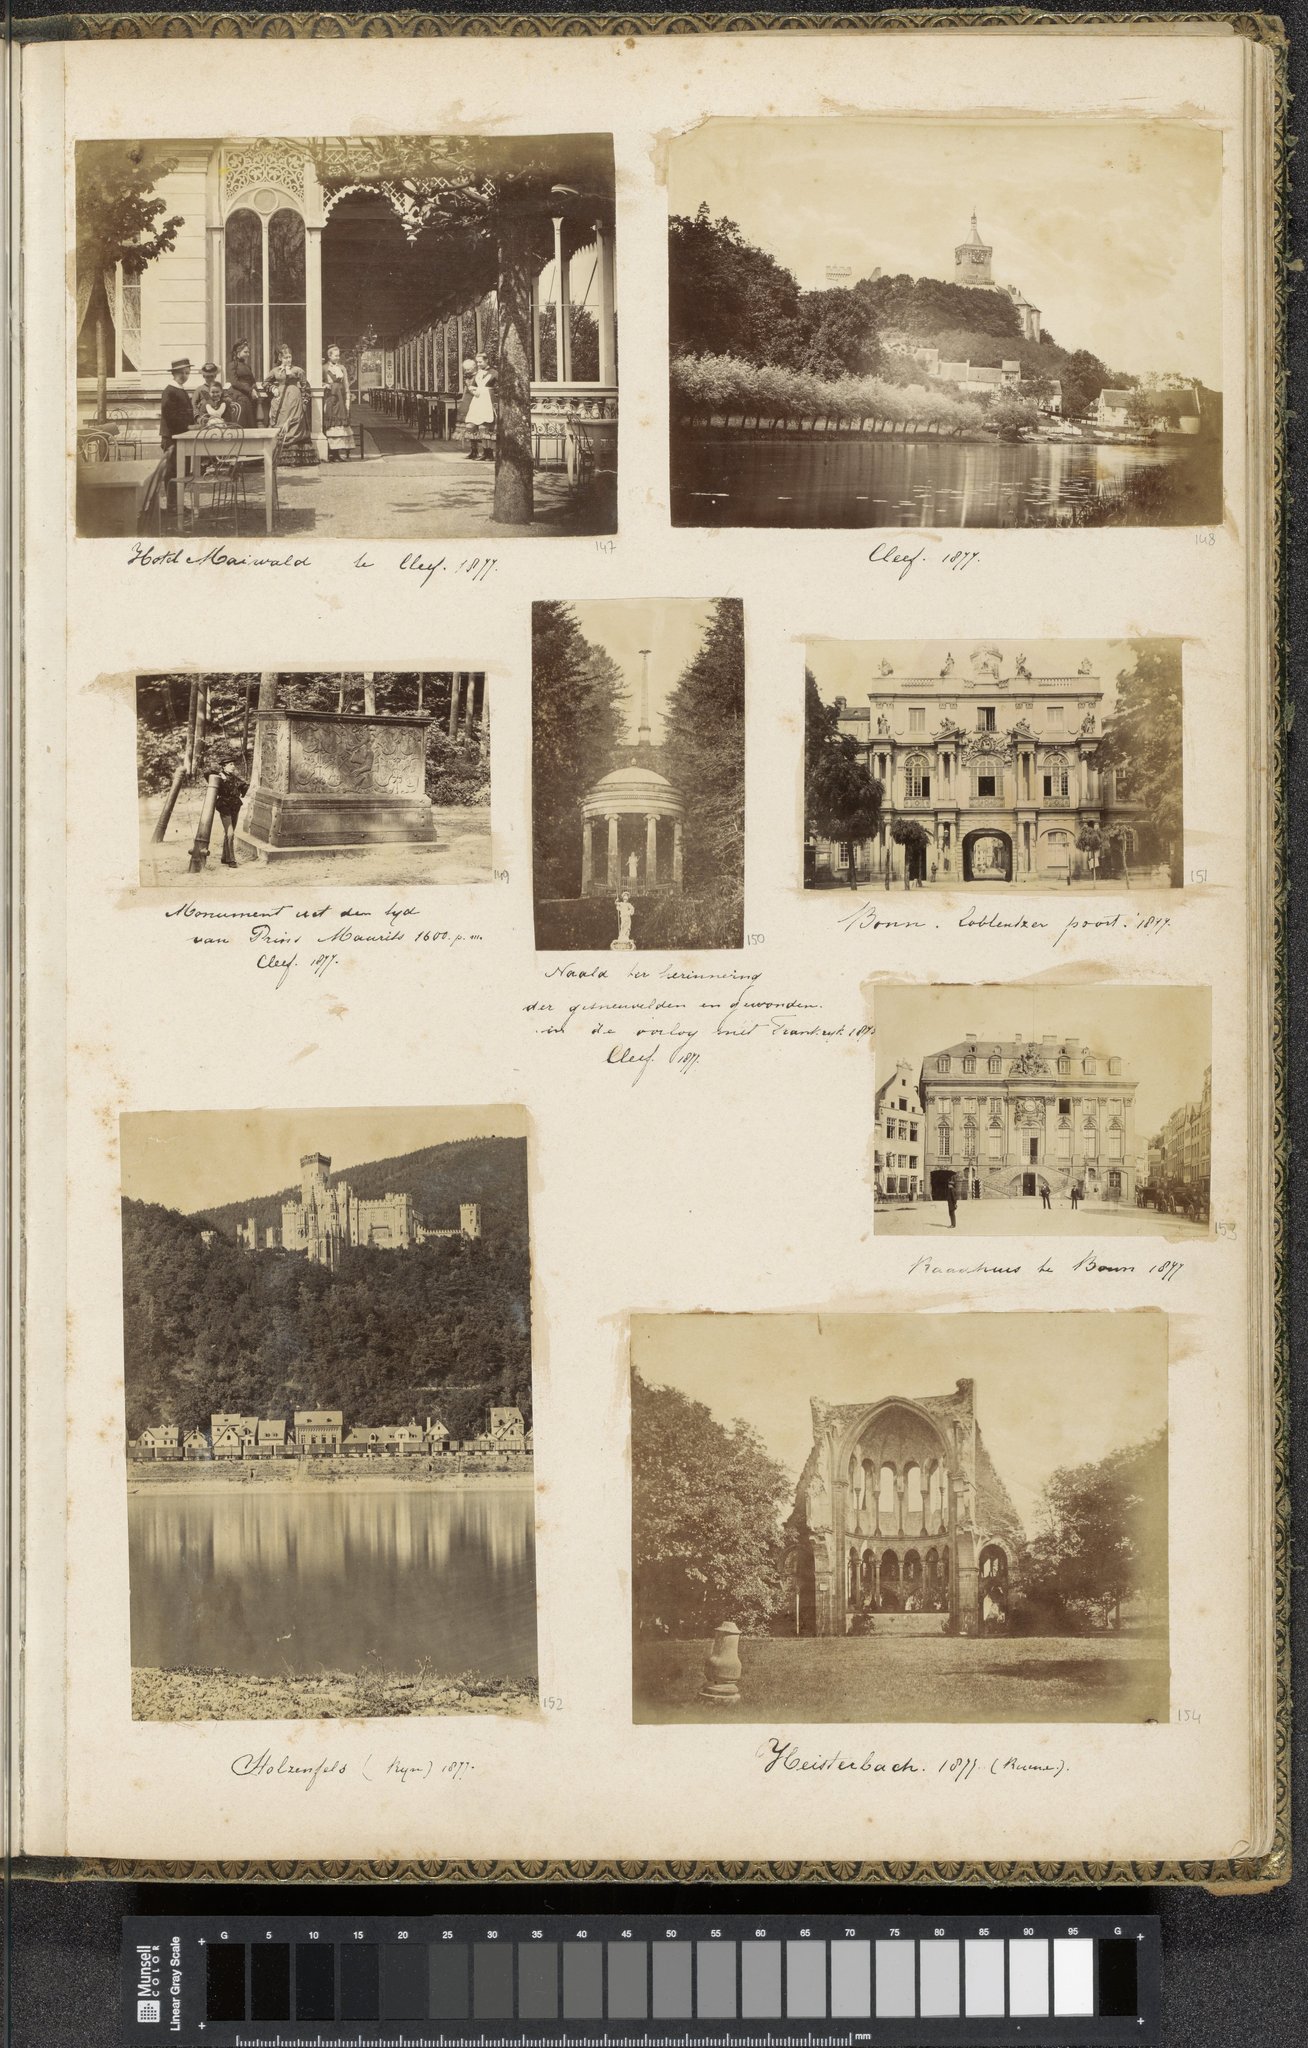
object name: photograph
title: Gezicht op Kleef met toren en water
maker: Anonymous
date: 1877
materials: paper, photographic support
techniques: albumen print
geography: cleves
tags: prospect of village, silhouette of village, tower, clock tower ~ monumental adornment, cleves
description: Onderdeel van Fotoalbum van Robert Daniel Crommelin (1841-1907).